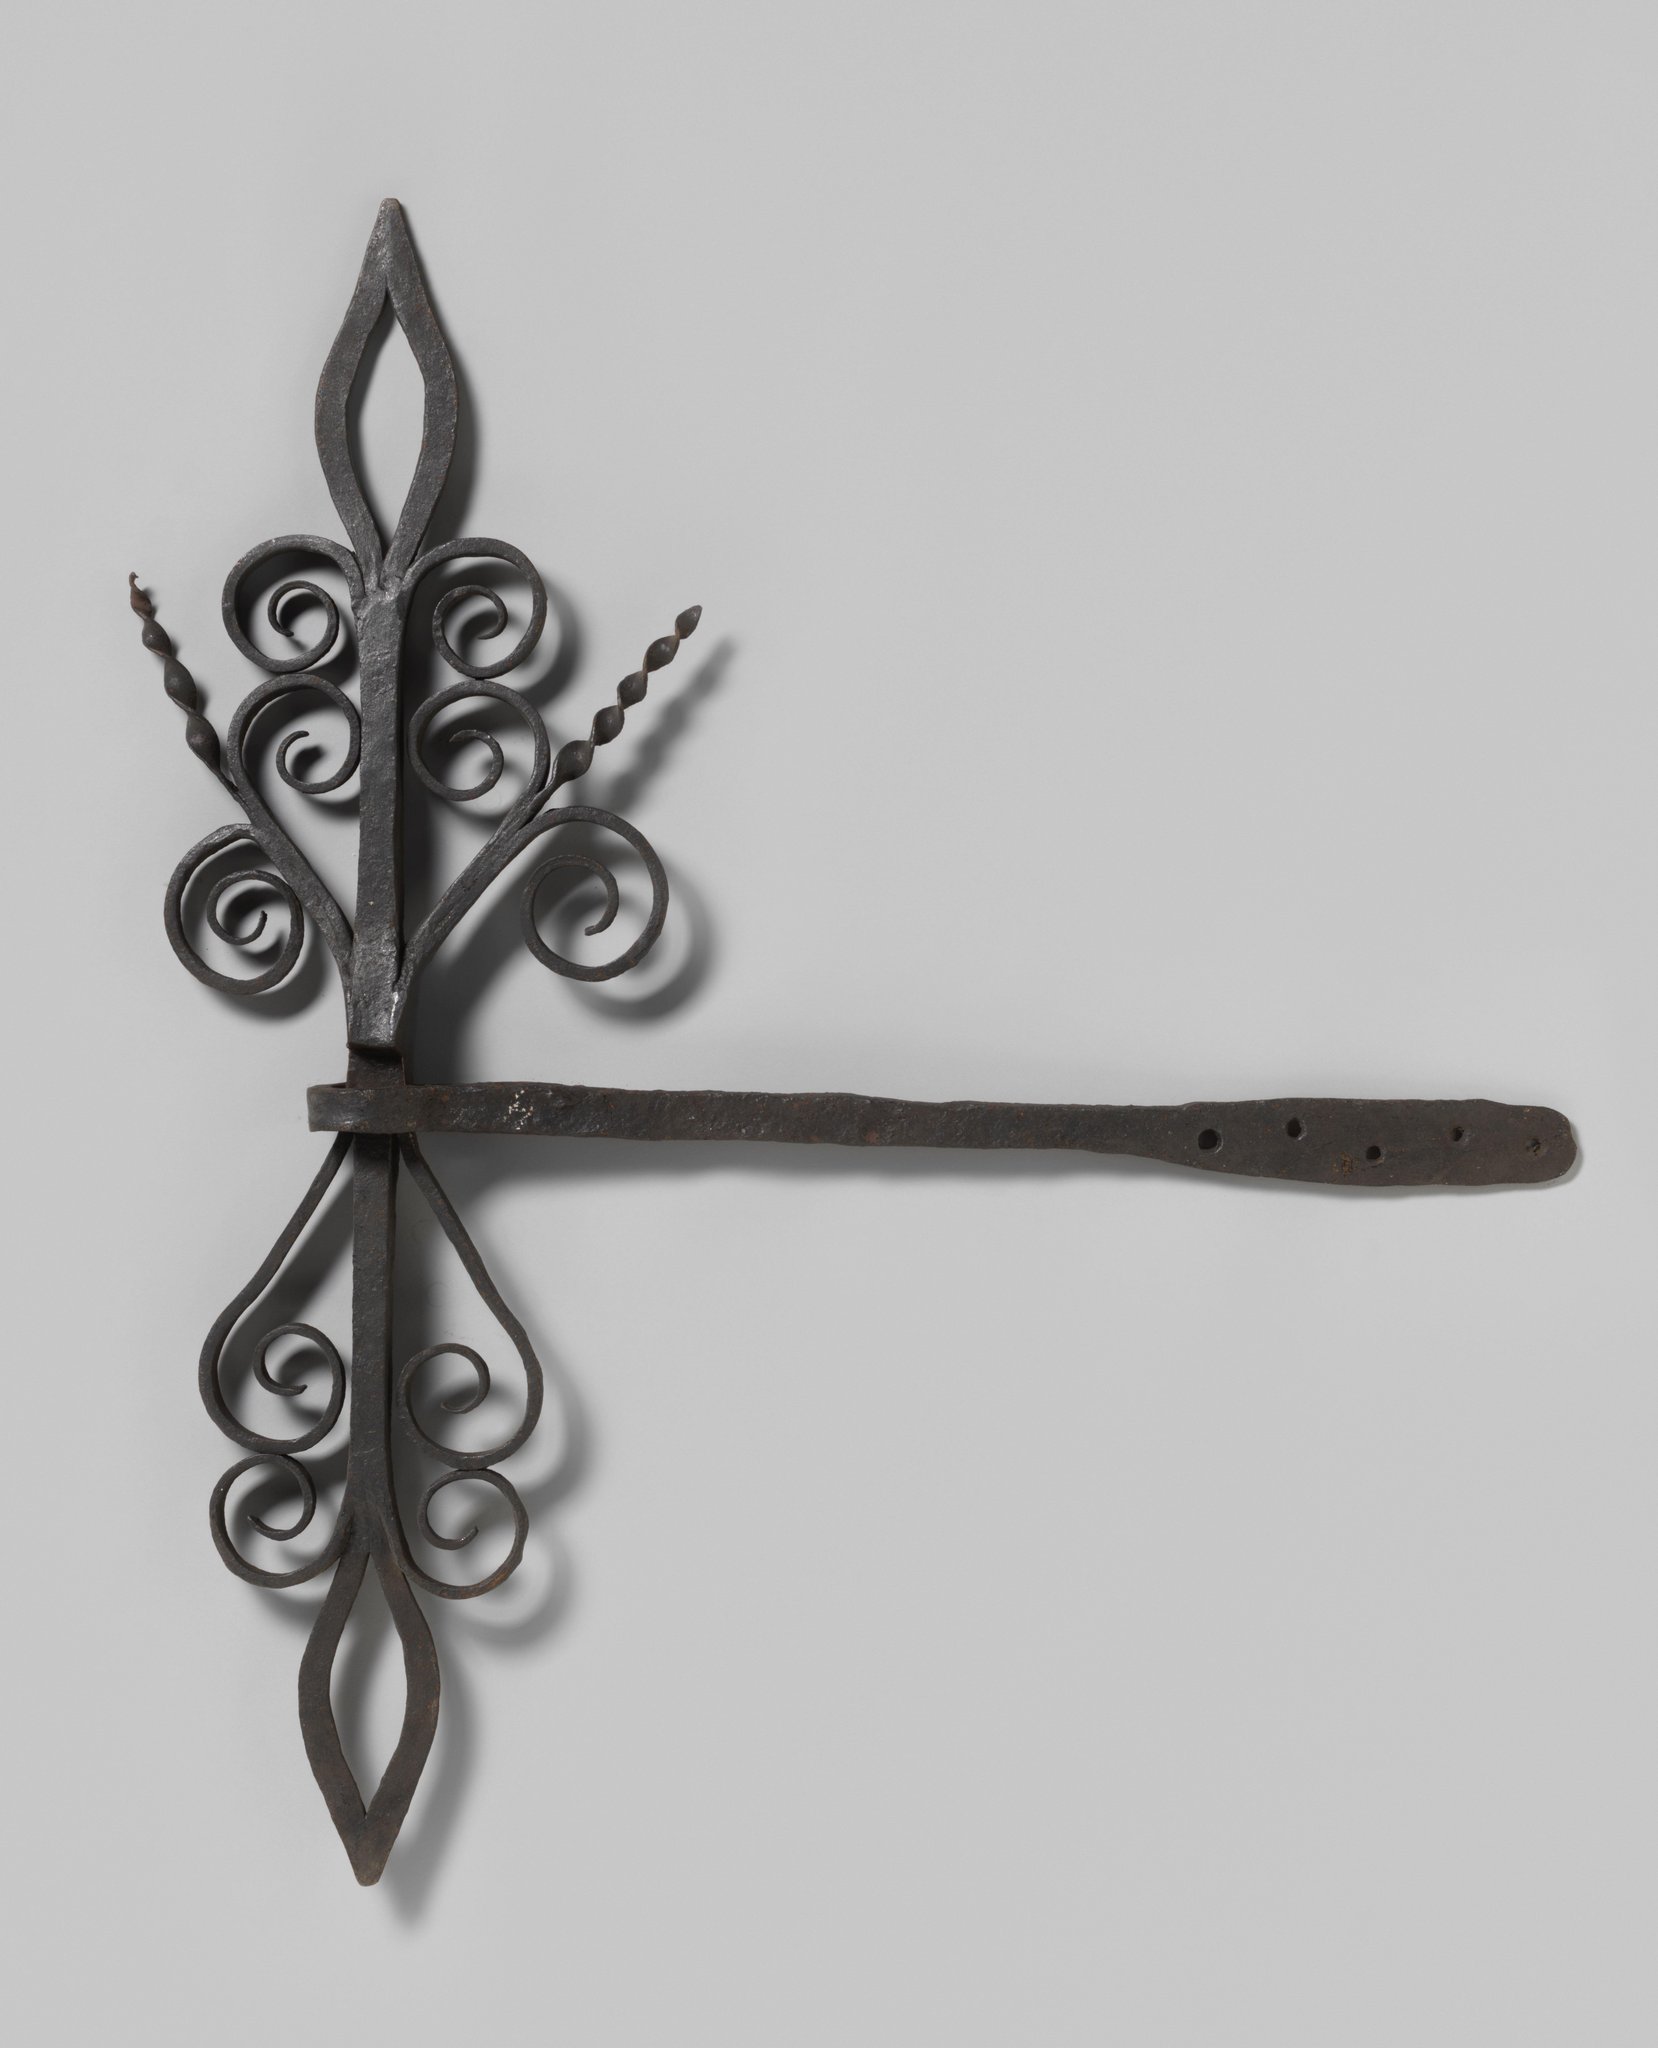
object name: beam anchor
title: Gevelanker afkomstig van woonhuis te Hattem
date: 1600-1699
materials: iron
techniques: forging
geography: hattem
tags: hattem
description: Een gevelanker van een gesloopt 17de eeuwse woonhuis te Hattem.